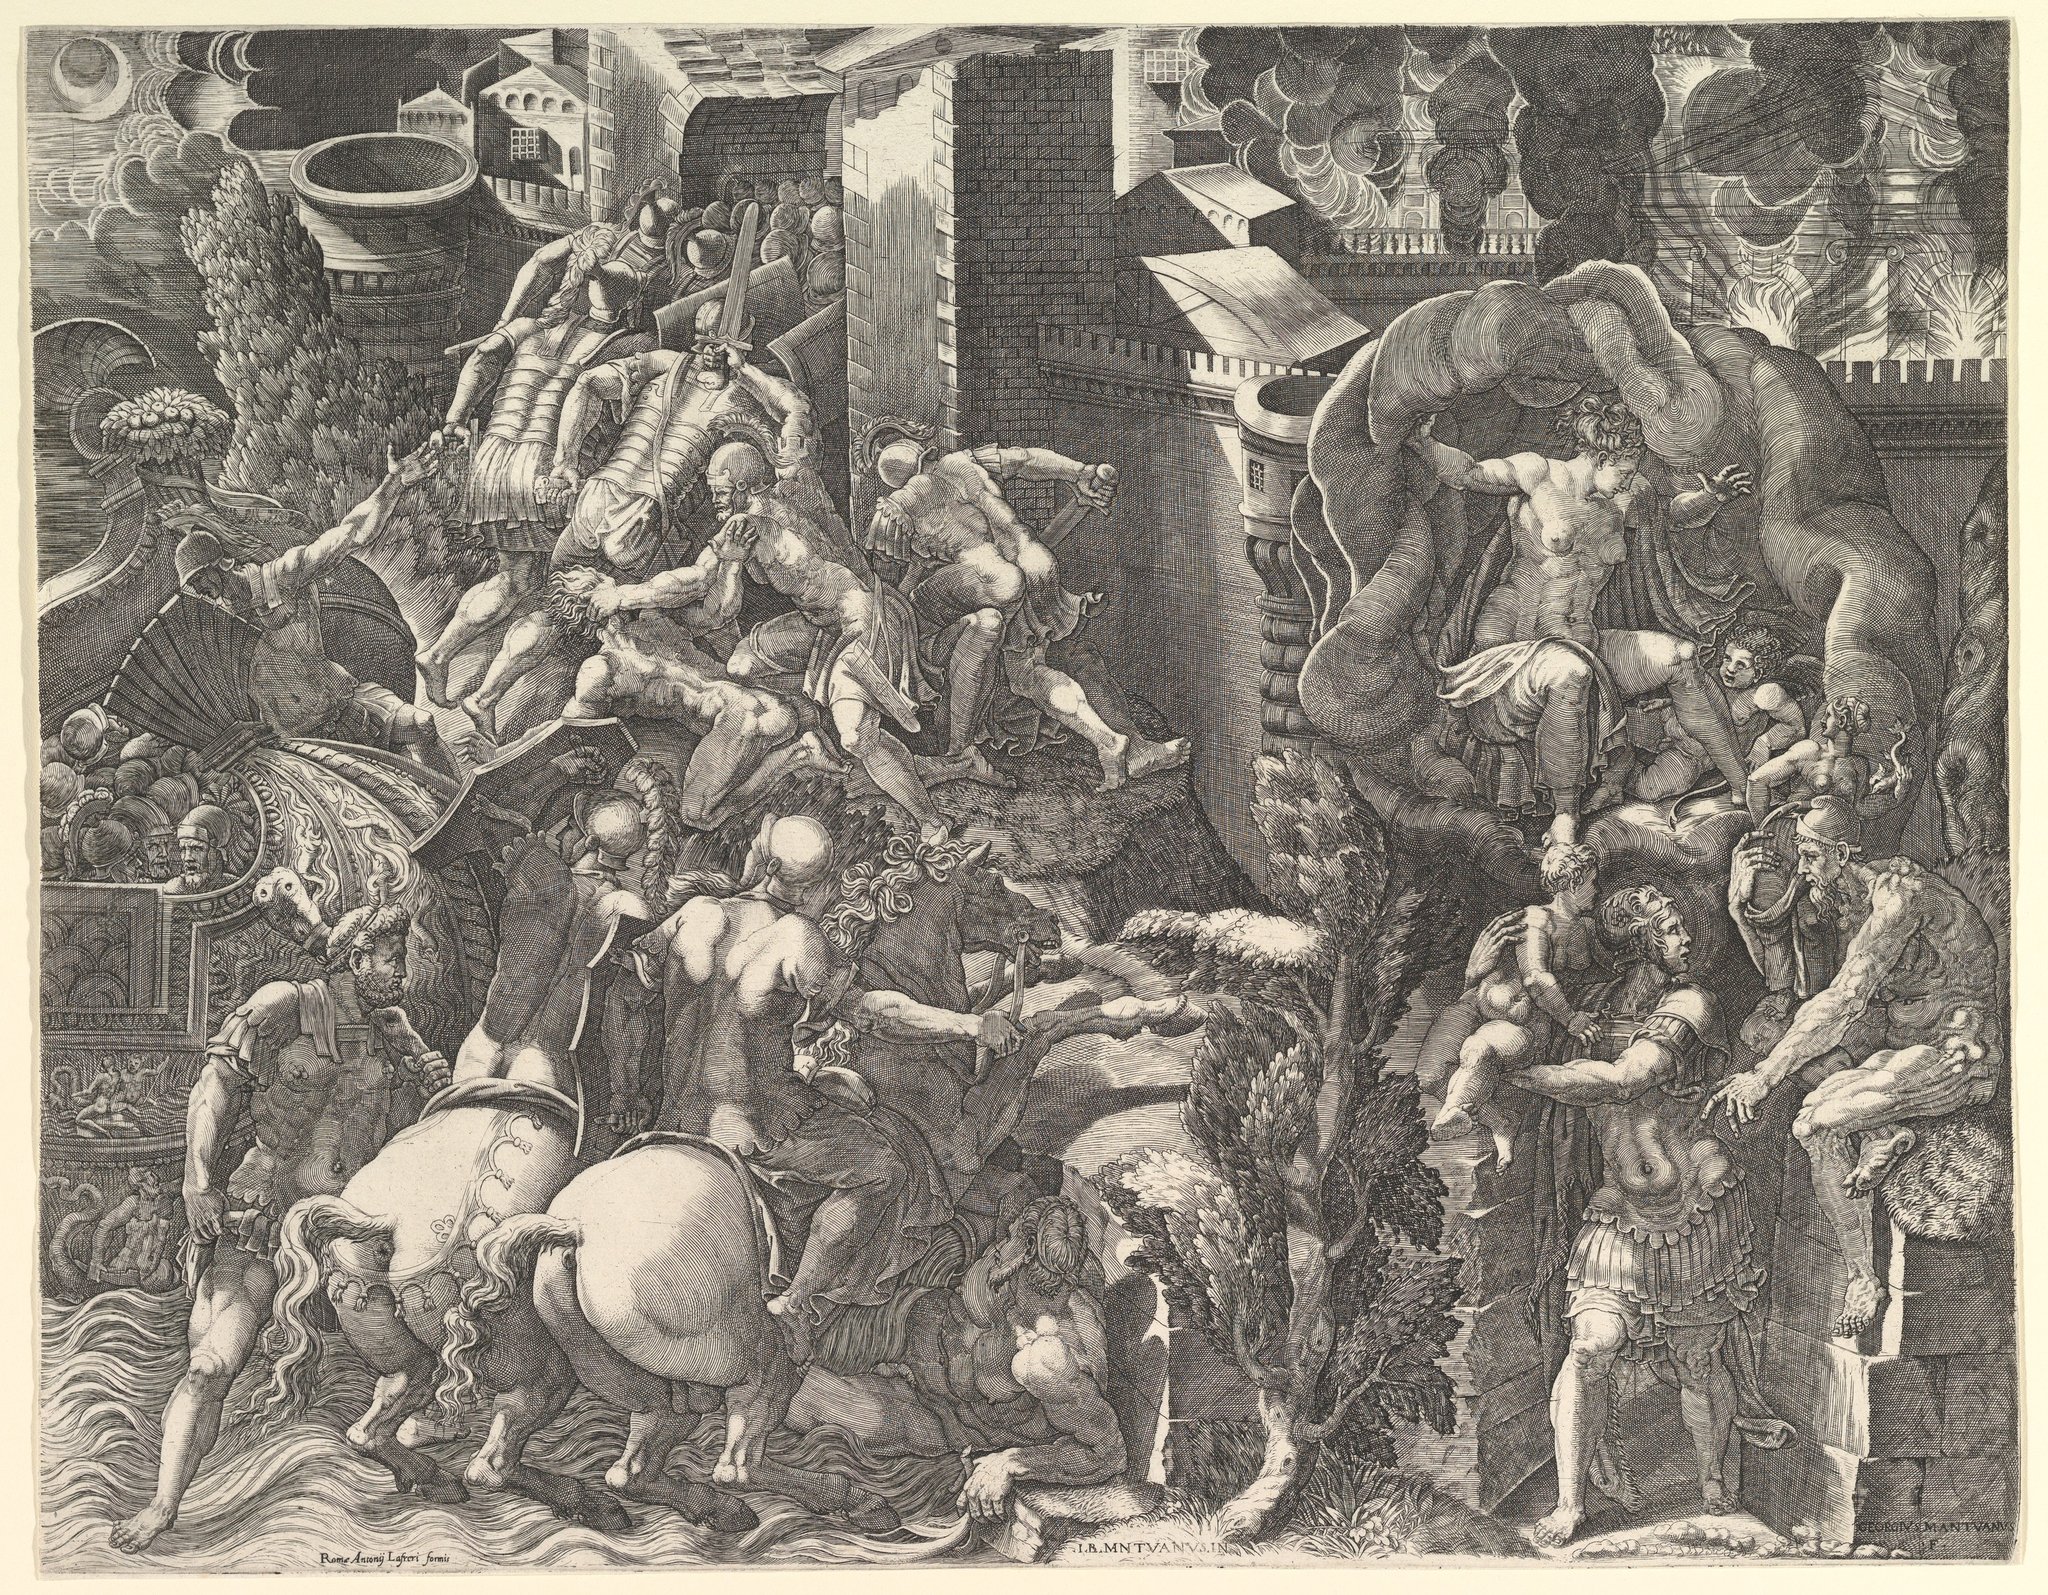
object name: print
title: The Fall of Troy and the Escape of Aeneas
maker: giorgio ghisi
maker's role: artist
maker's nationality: italian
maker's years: 1515-1582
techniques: engraving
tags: trojan war,men,horses